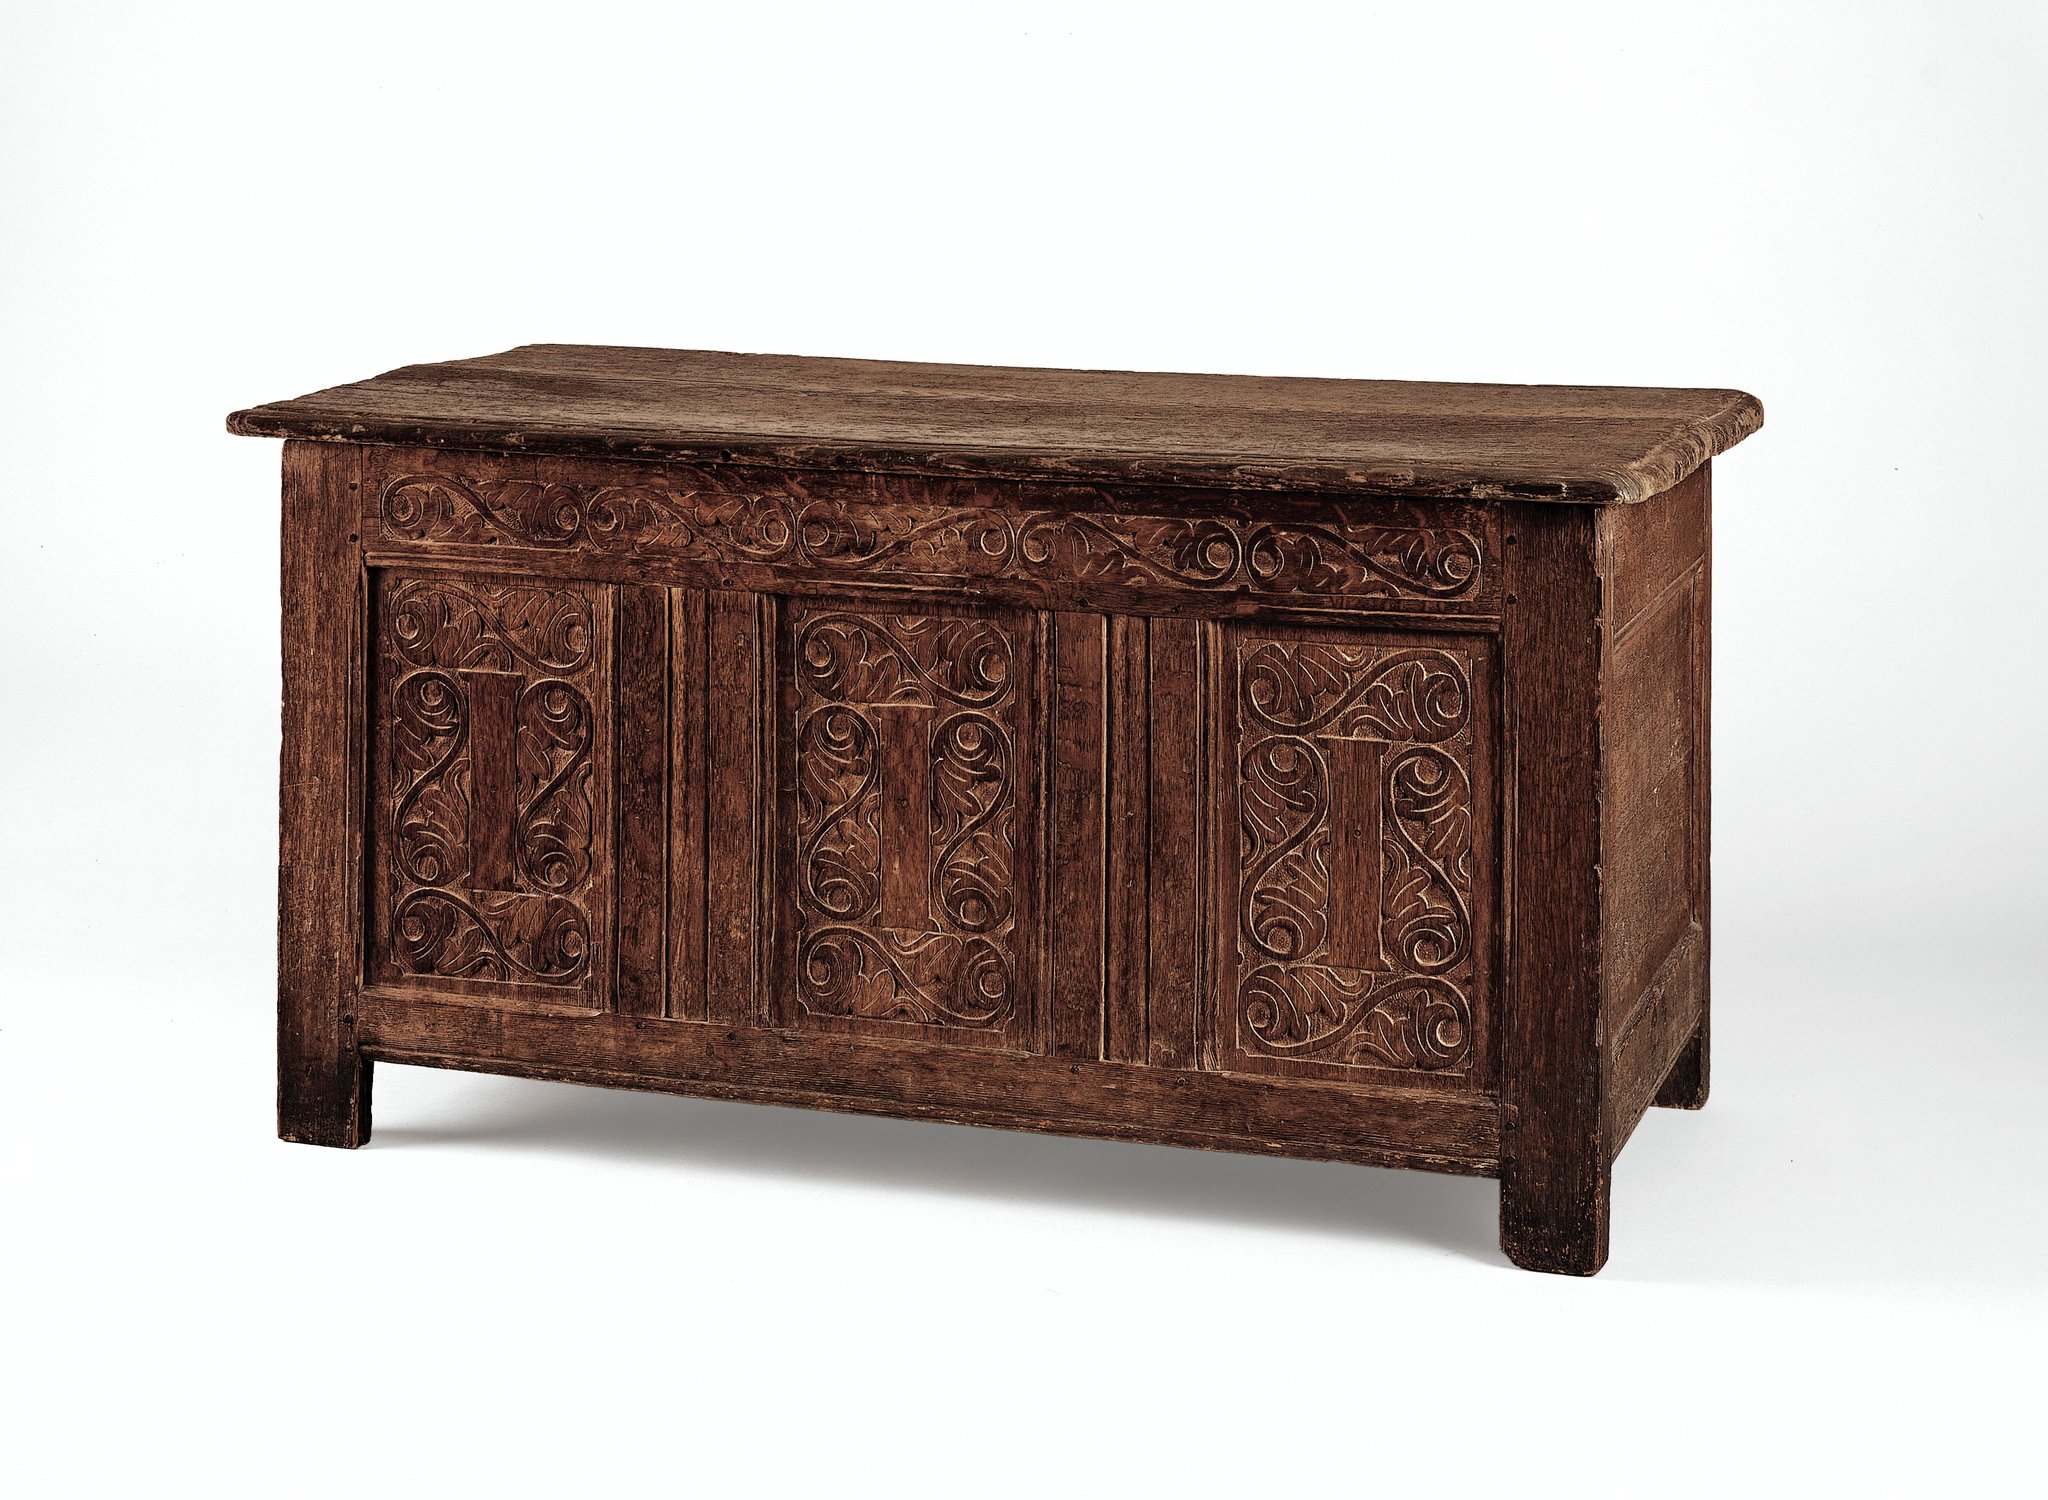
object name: chest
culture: american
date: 1650-1700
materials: wood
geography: united states